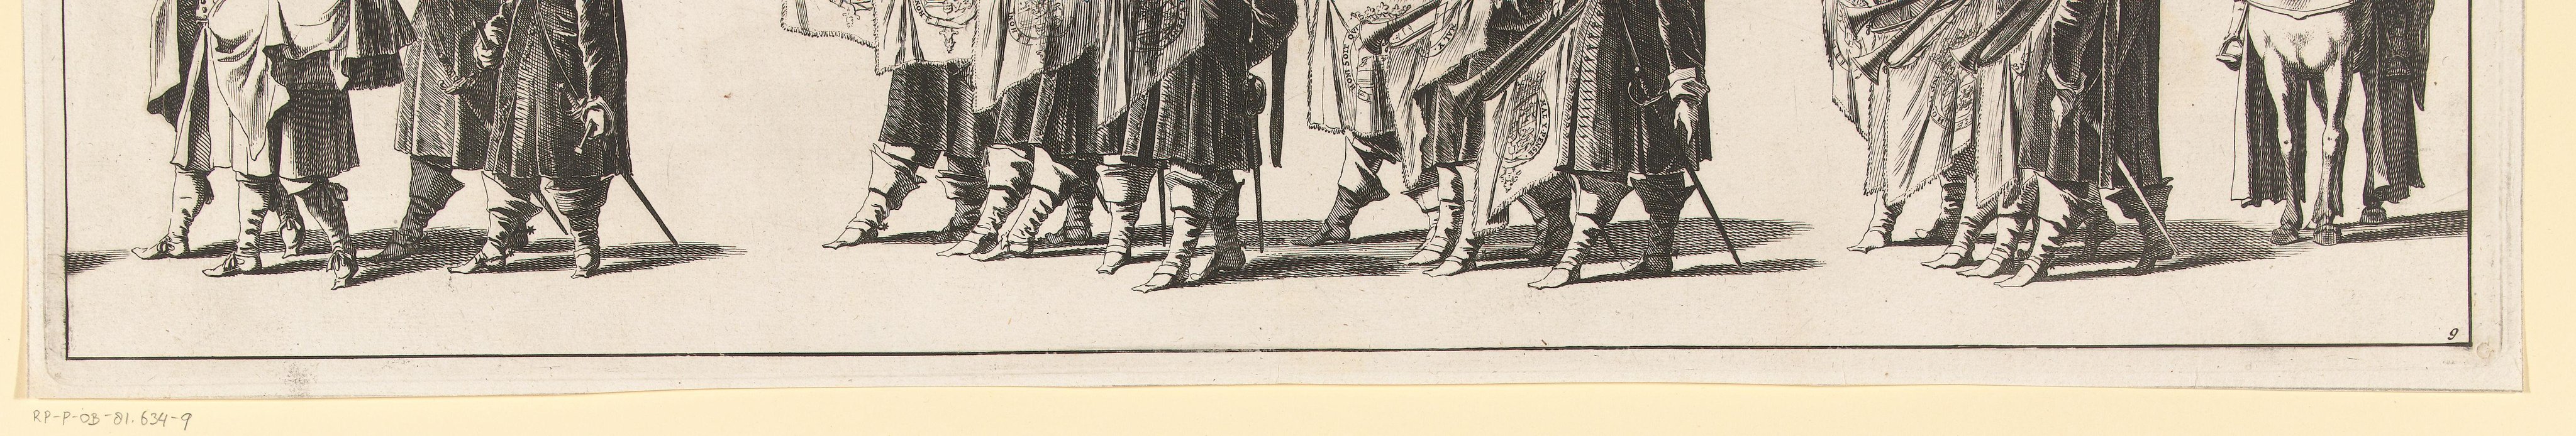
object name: print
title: De begrafenisstoet van stadhouder Frederik Hendrik te 's-Gravenhage in 1647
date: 1647-1651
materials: paper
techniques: etching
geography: the hague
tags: frederick henry (prince of orange), cortege, funeral procession, the hague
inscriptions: collector's mark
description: De begrafenisstoet van stadhouder Frederik Hendrik te 's-Gravenhage op 10 mei 1647. Plaat nr. 10 met een deel van de stoet met vaandeldragers en een paard, boven de personen staan hun naam en functie. Onderdeel van een serie van 30 platen en 20 tekstbladen, bedoeld om aan elkaar geplakt te worden.